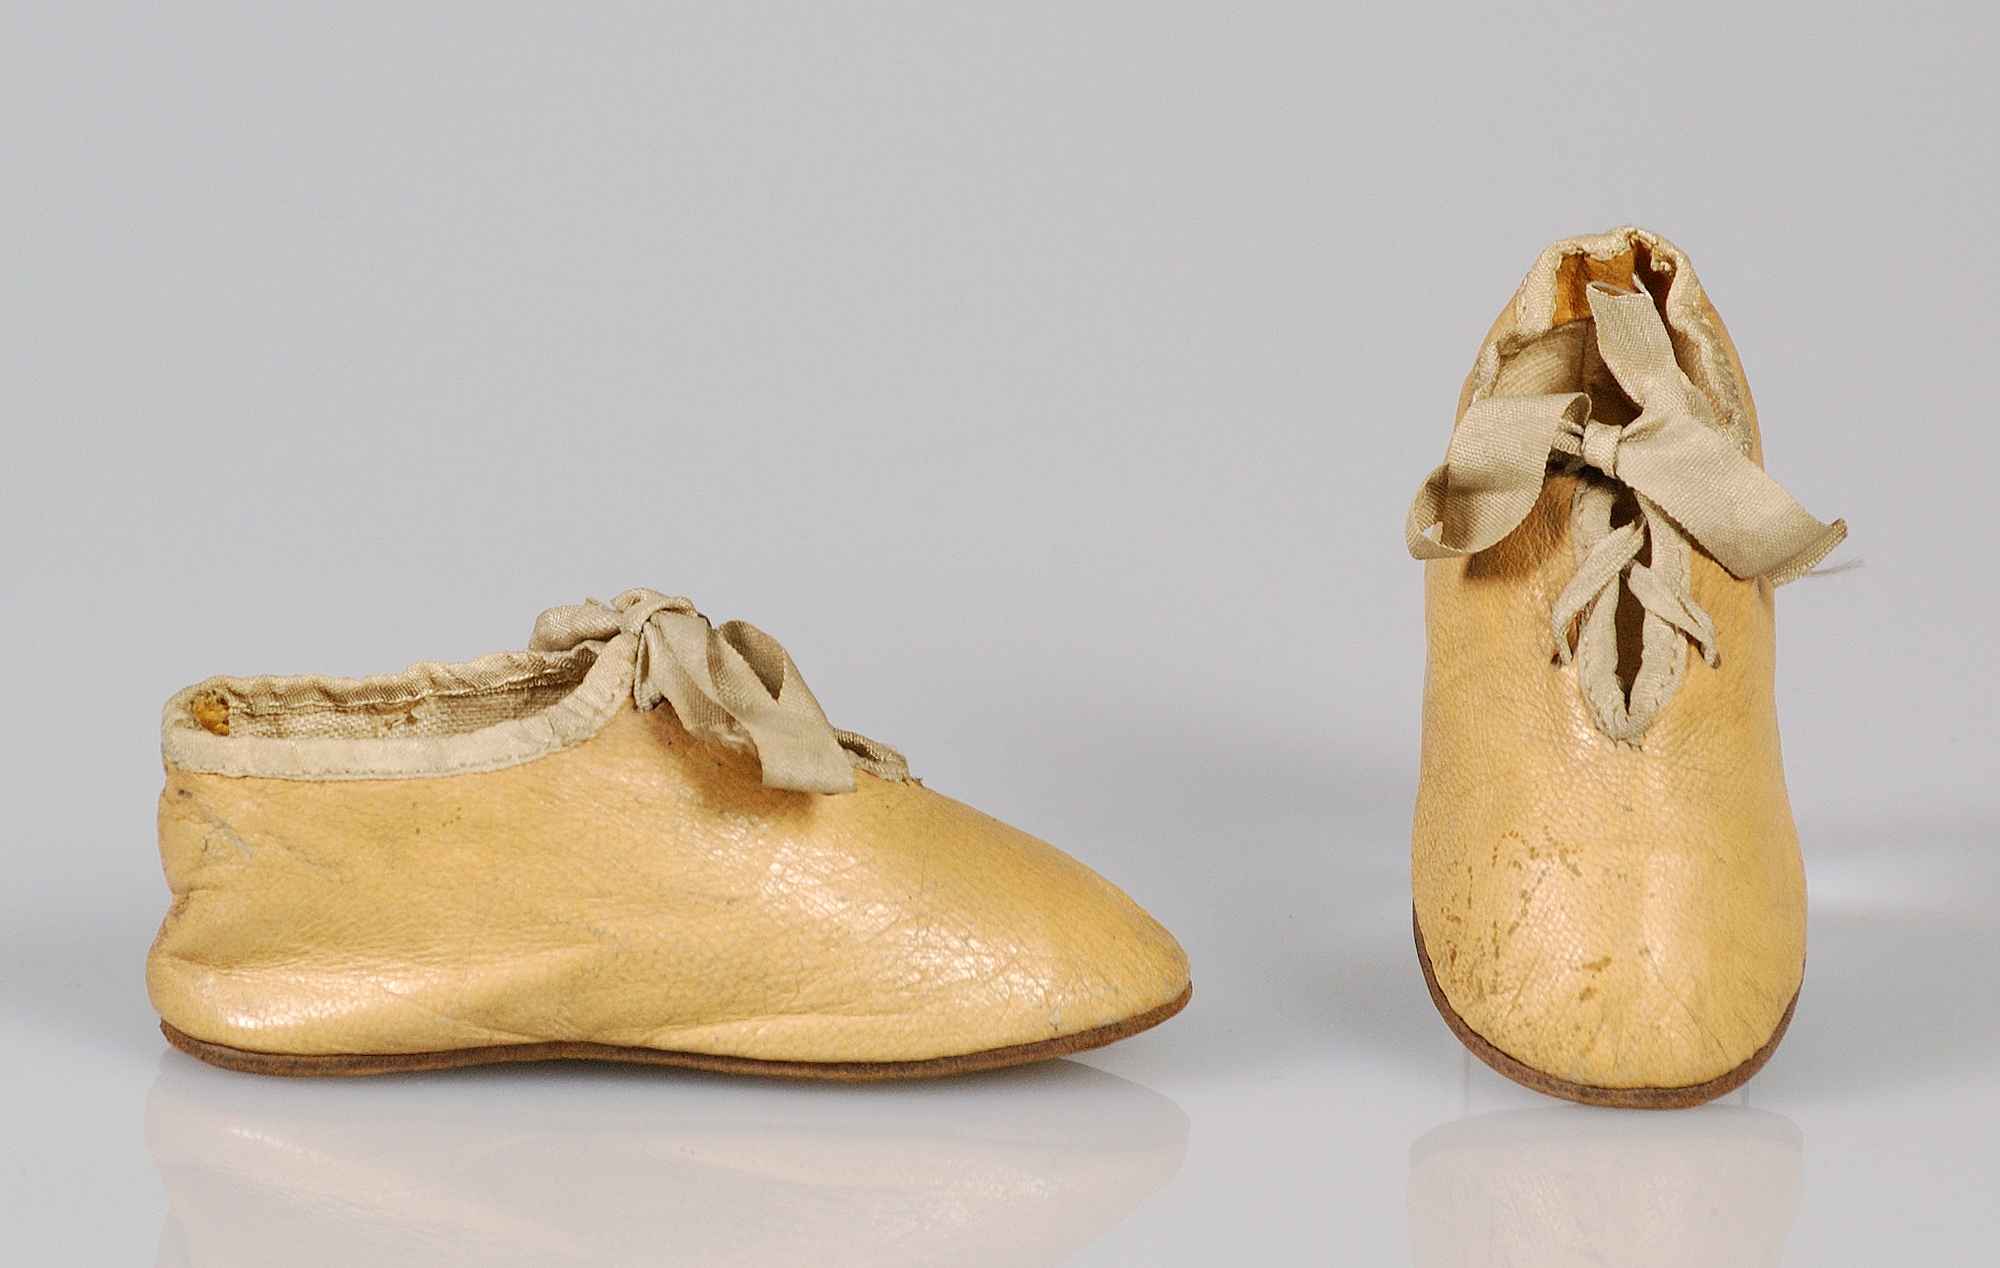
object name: shoe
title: Shoes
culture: european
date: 1801-1900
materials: leather